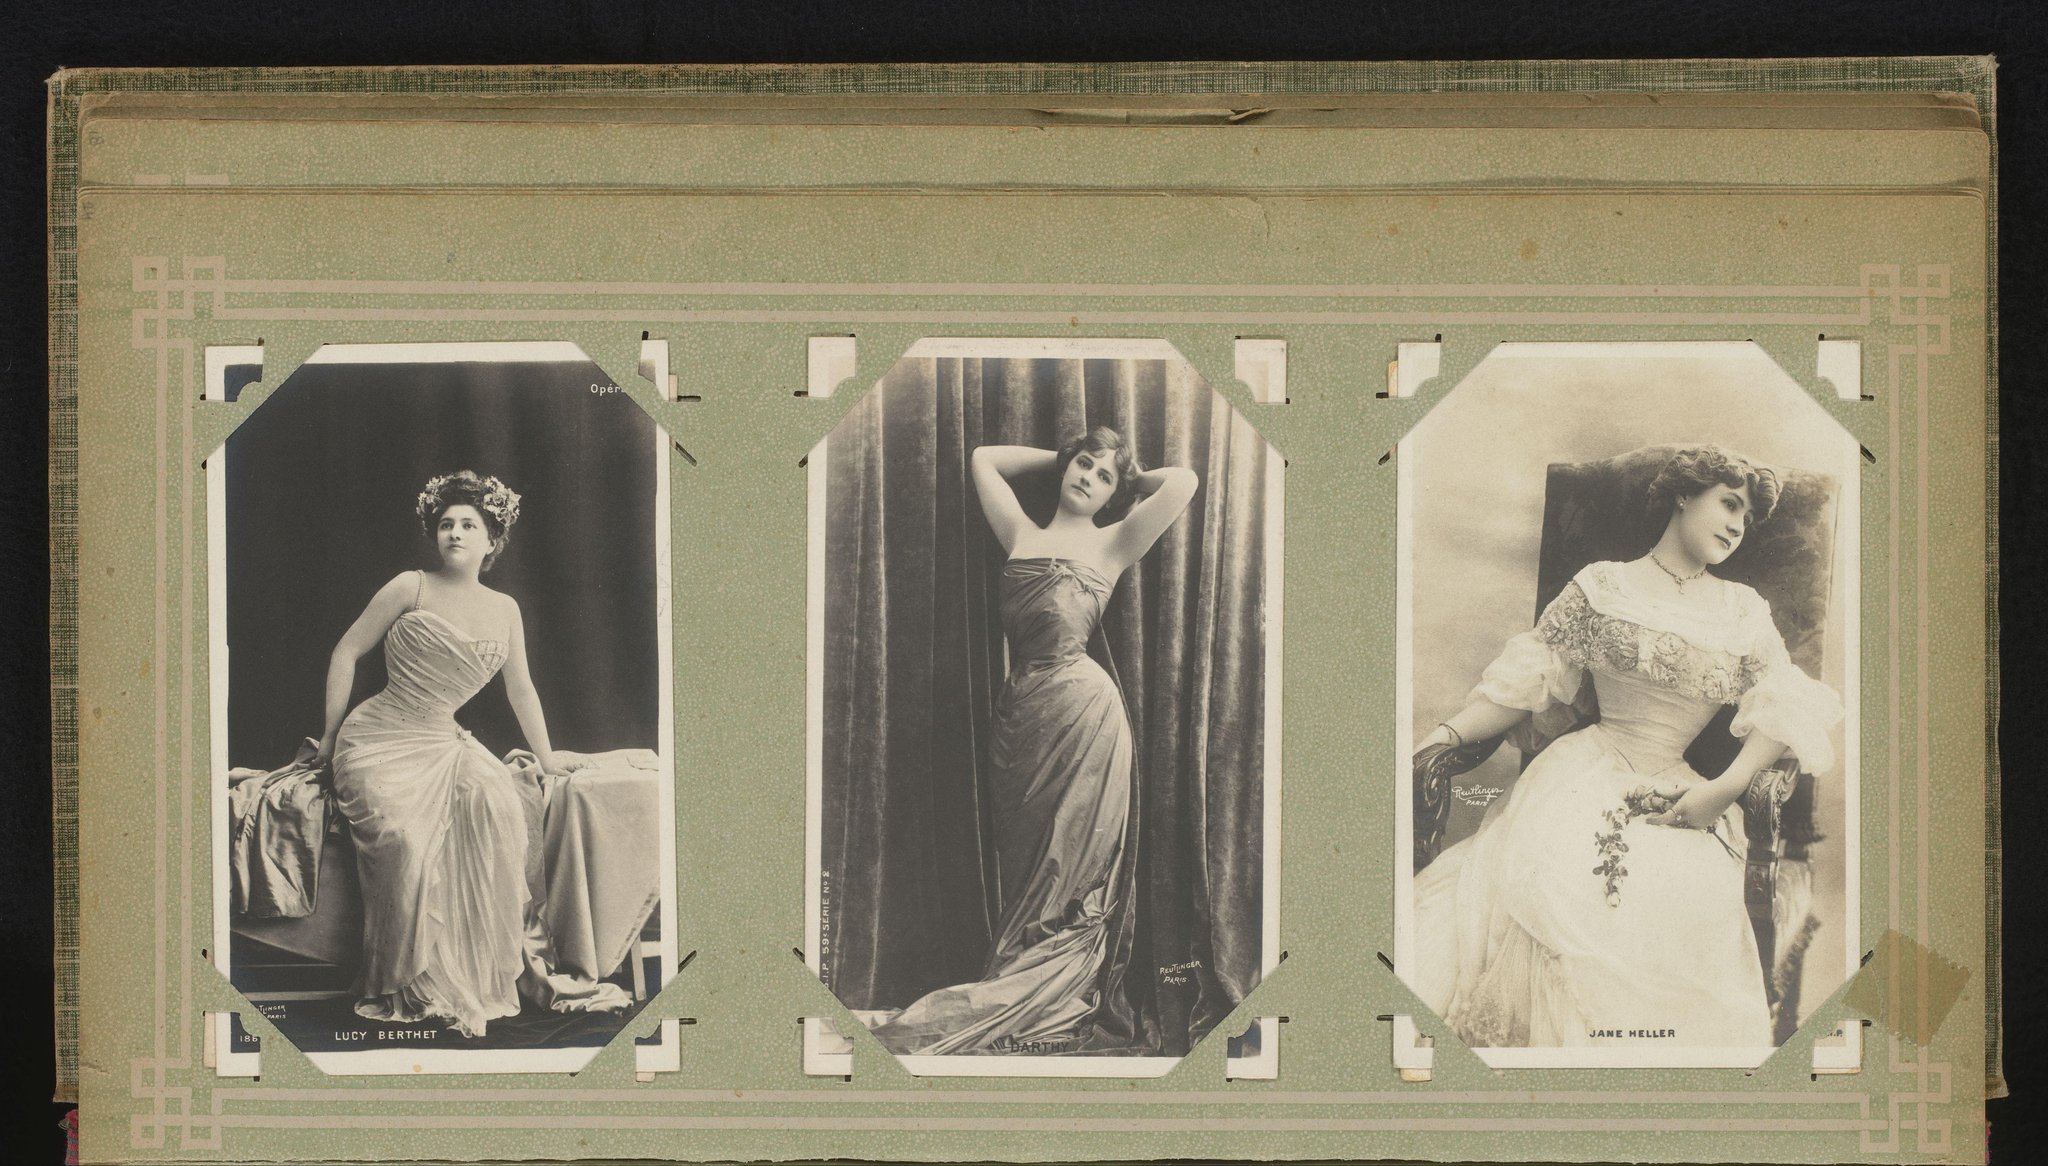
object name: photograph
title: Portretten van Lucy Berthet, Gilda Darthy en Jane Heller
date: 1900-1930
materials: cardboard, photographic support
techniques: gelatin silver print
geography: paris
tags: historical persons - bb - woman, portrait of actor, actress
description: Deze foto's maken deel uit van een album.